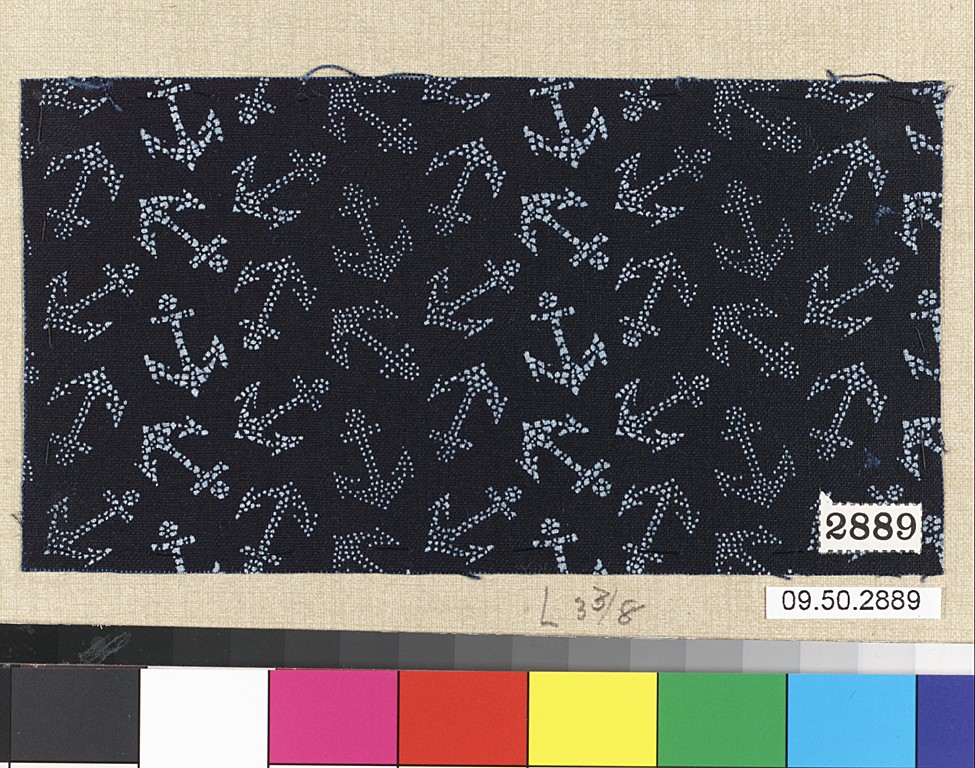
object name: piece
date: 1801-1900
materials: cotton